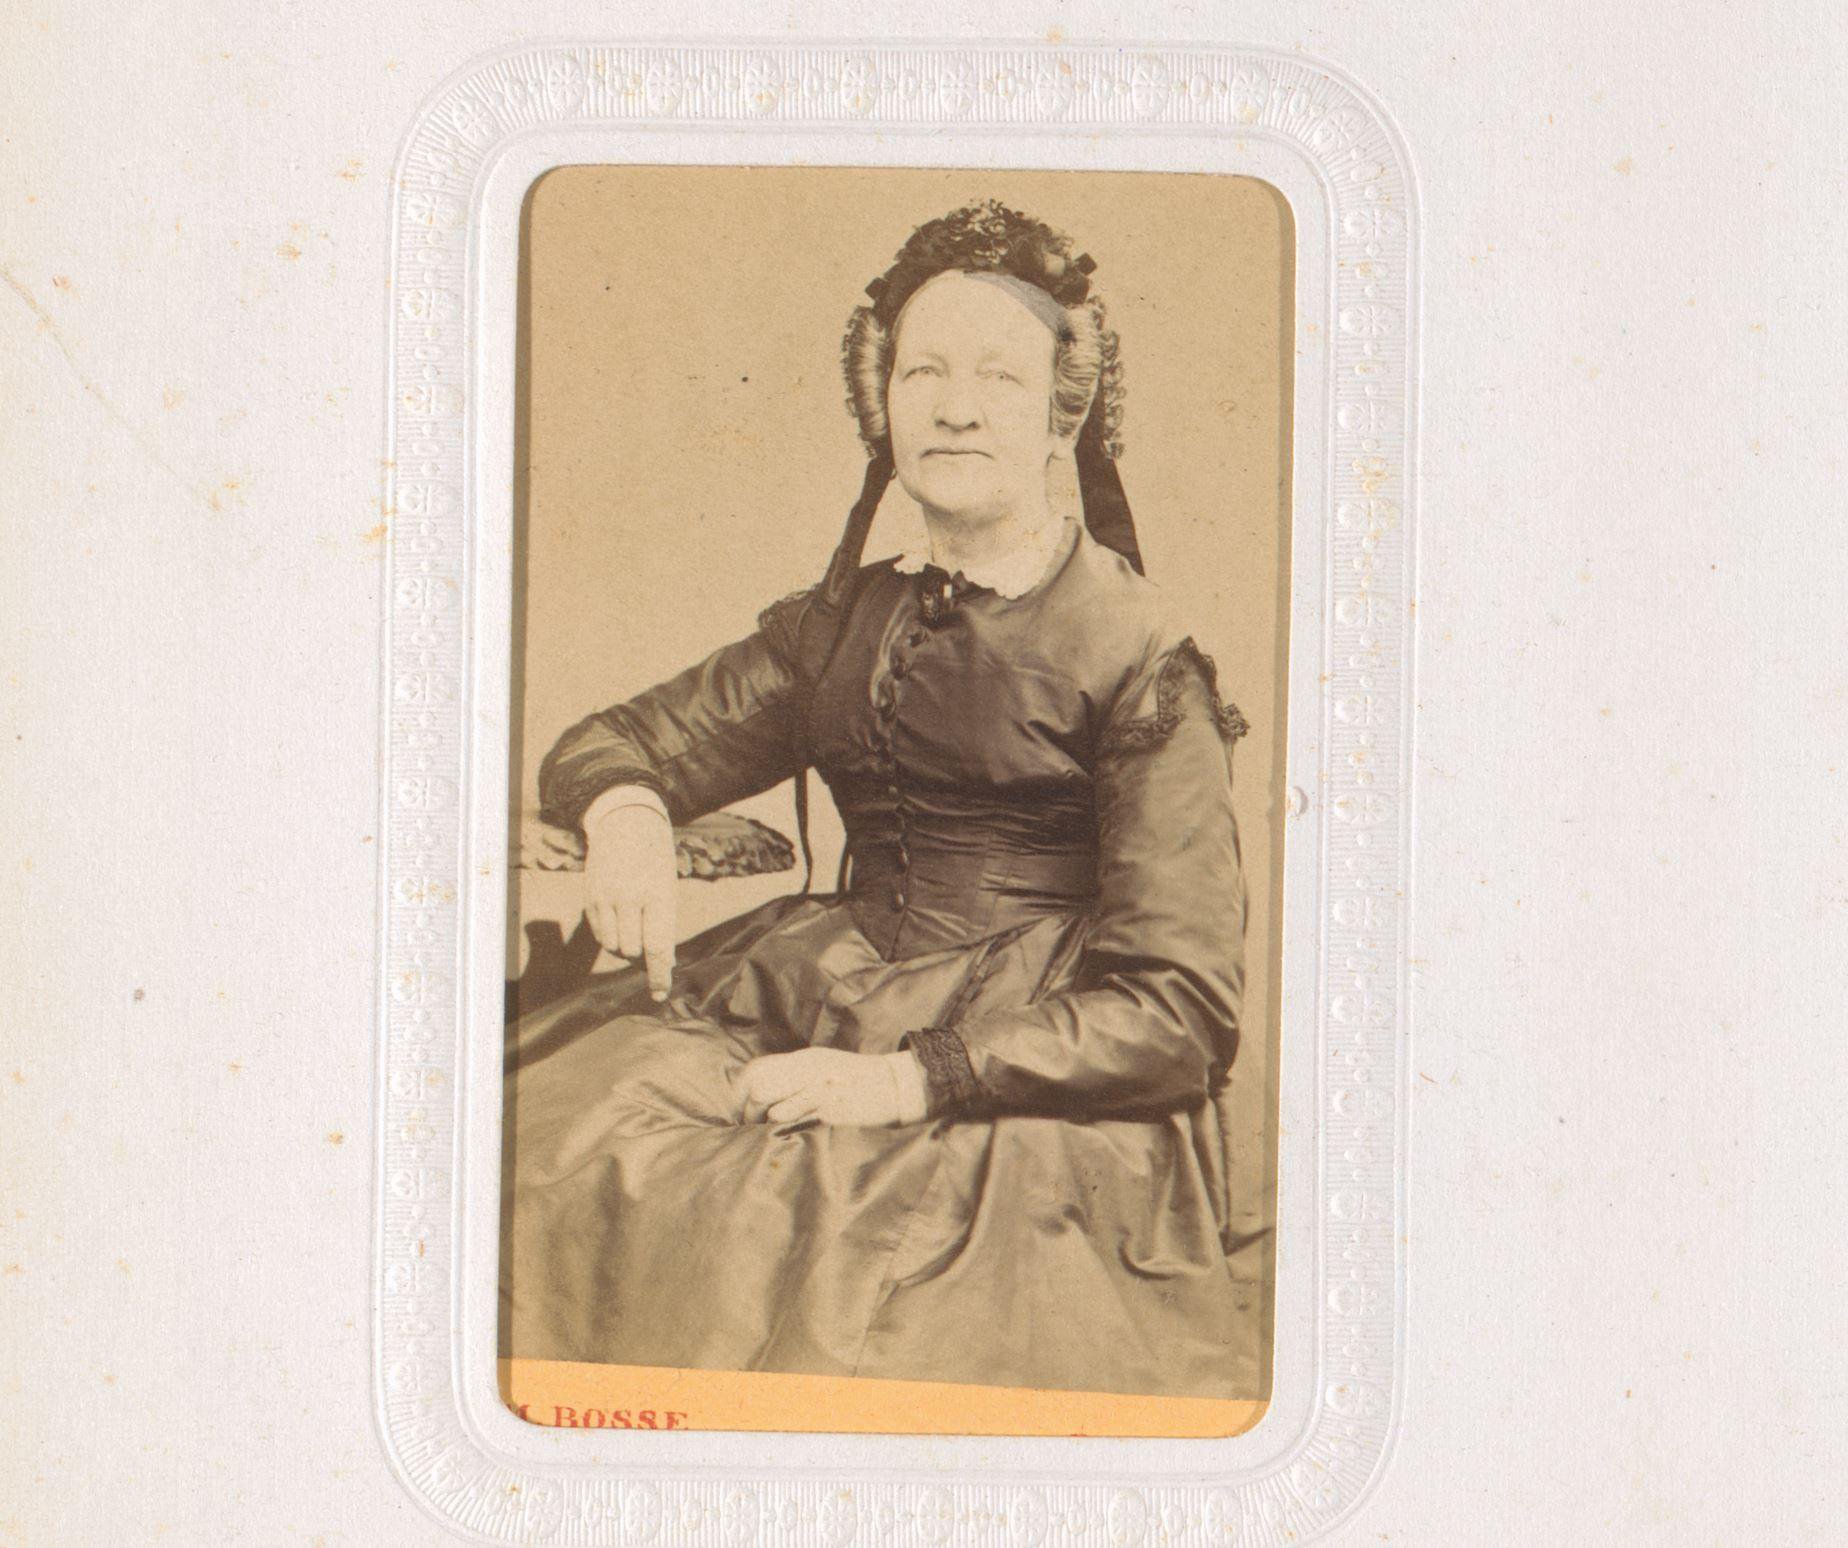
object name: album leaf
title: Portret van een zittende oude vrouw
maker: johann heinrich martin bosse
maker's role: fotograaf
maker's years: 1838-1901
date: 1850-1880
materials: cardboard, photographic support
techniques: albumen print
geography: deventer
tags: historical persons - bb - woman, old woman